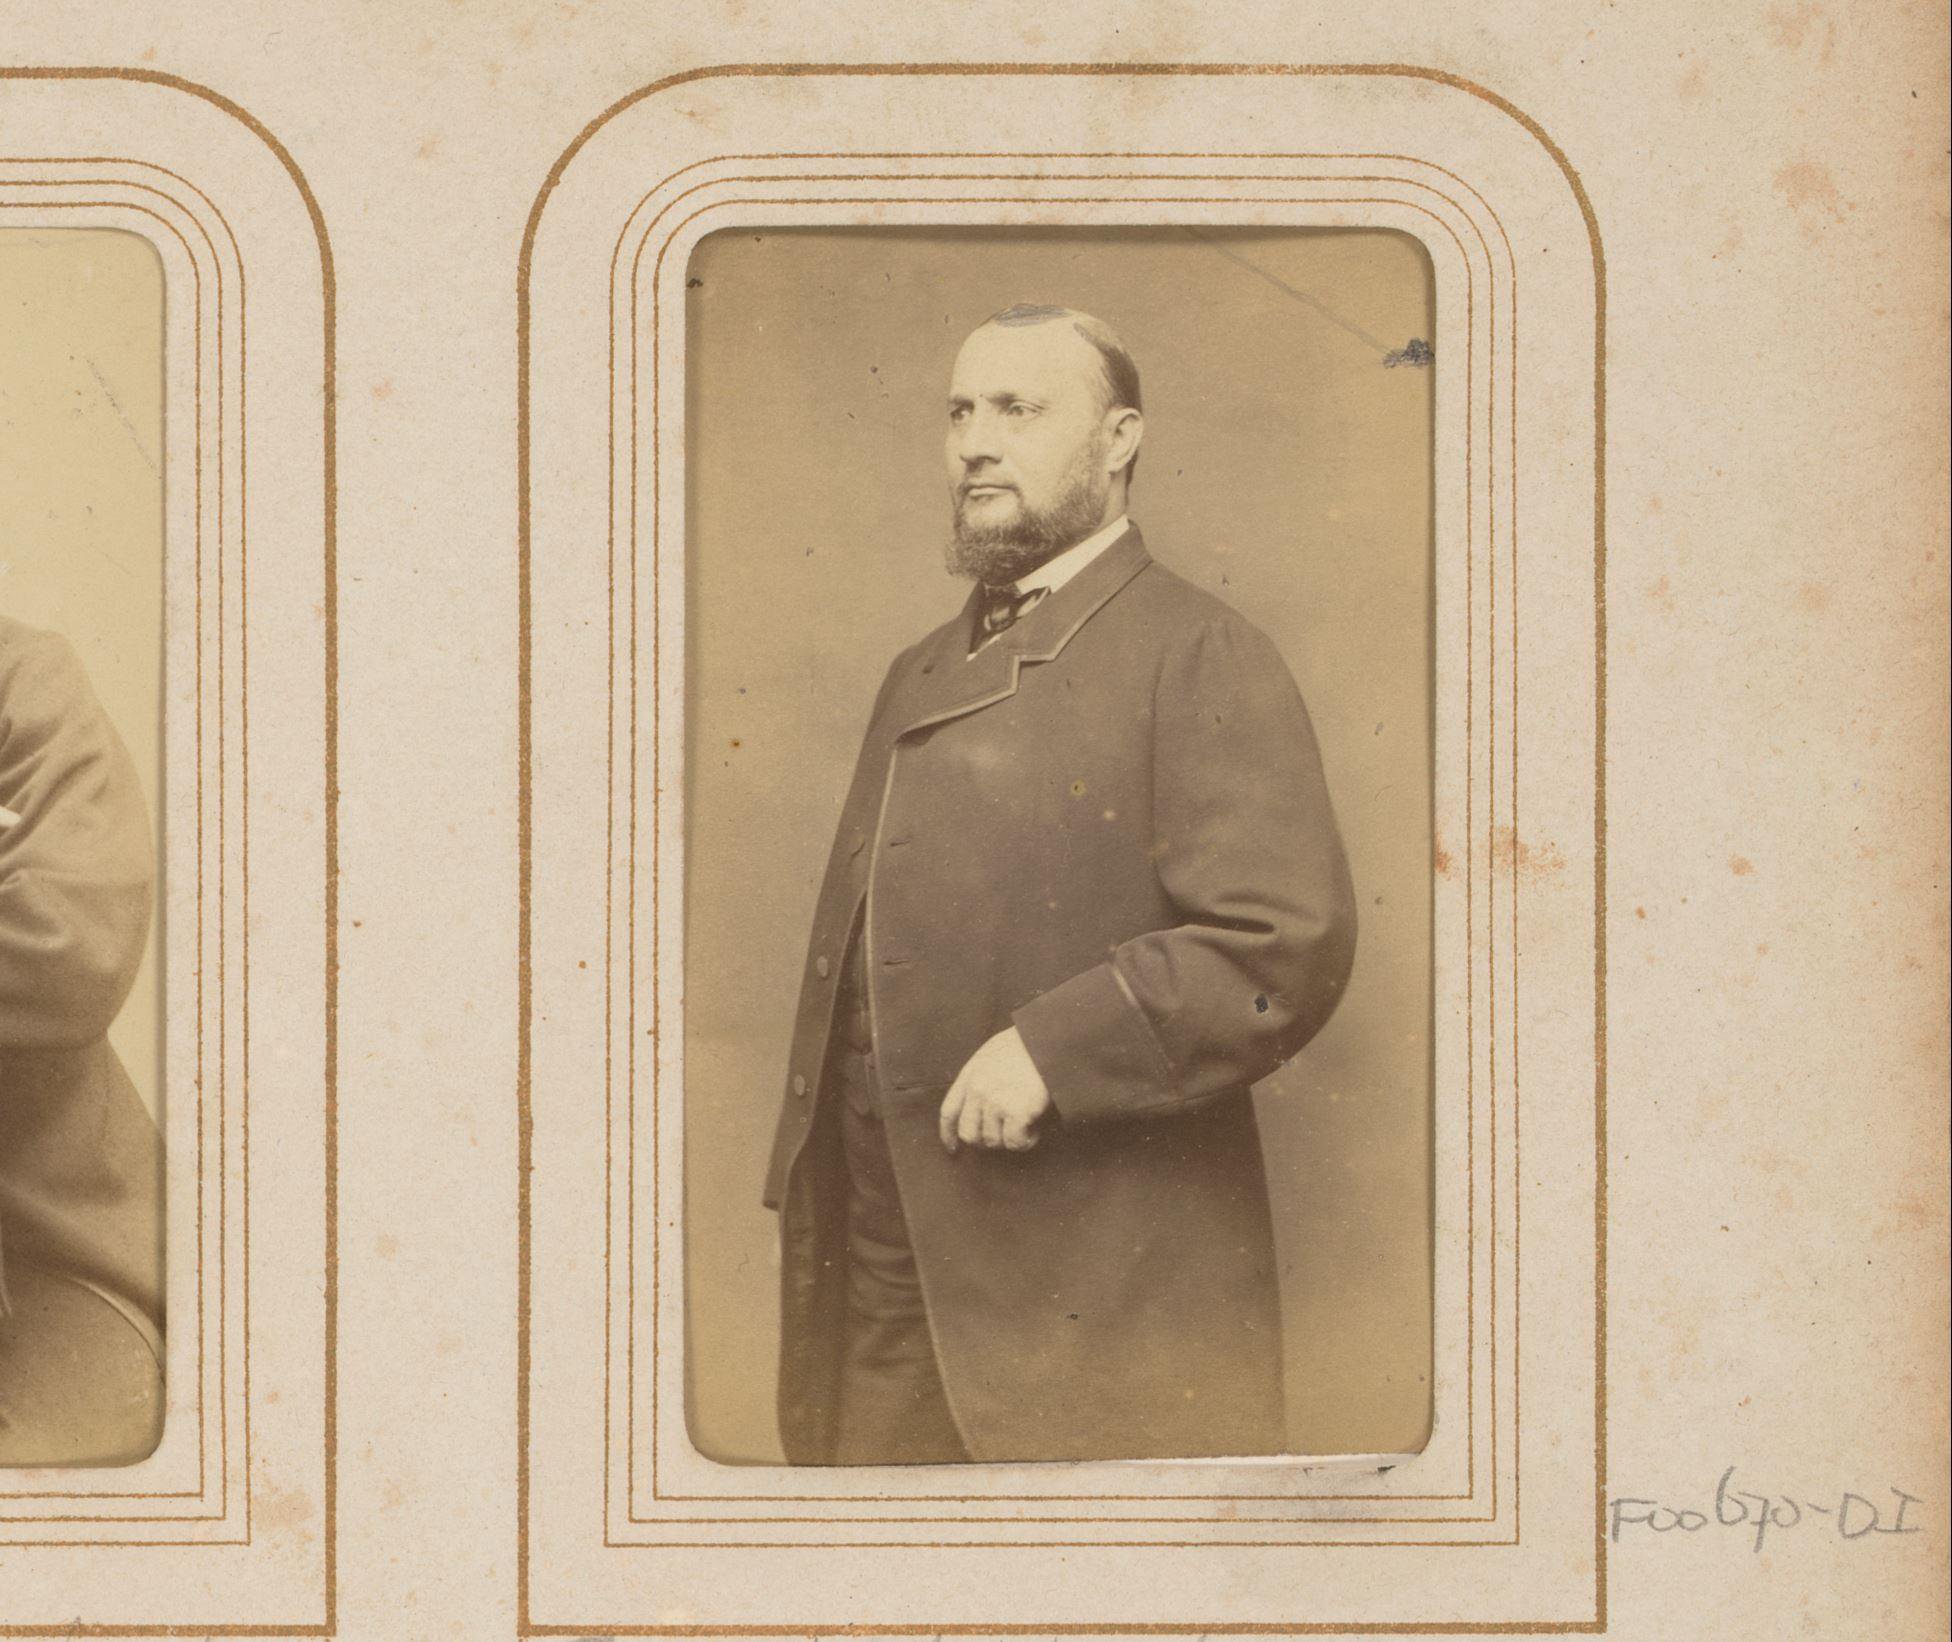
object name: carte de visite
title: Portret van Tamberlick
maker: georges mathurin legé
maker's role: fotograaf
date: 1867-1872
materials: cardboard, photographic support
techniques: albumen print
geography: paris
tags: historical persons, opera-singer (male)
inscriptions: annotation: ‘Tamberlik Ital operazanger/ [...] 1819-1889/ (Legé - Carjat)’, name: ‘Tamberlik’, inscription: ‘G.M. Legé/ Photographe/ ancien associé, succr/ De Carjat & Cie/ 56, Rue Laffitte/ Paris’